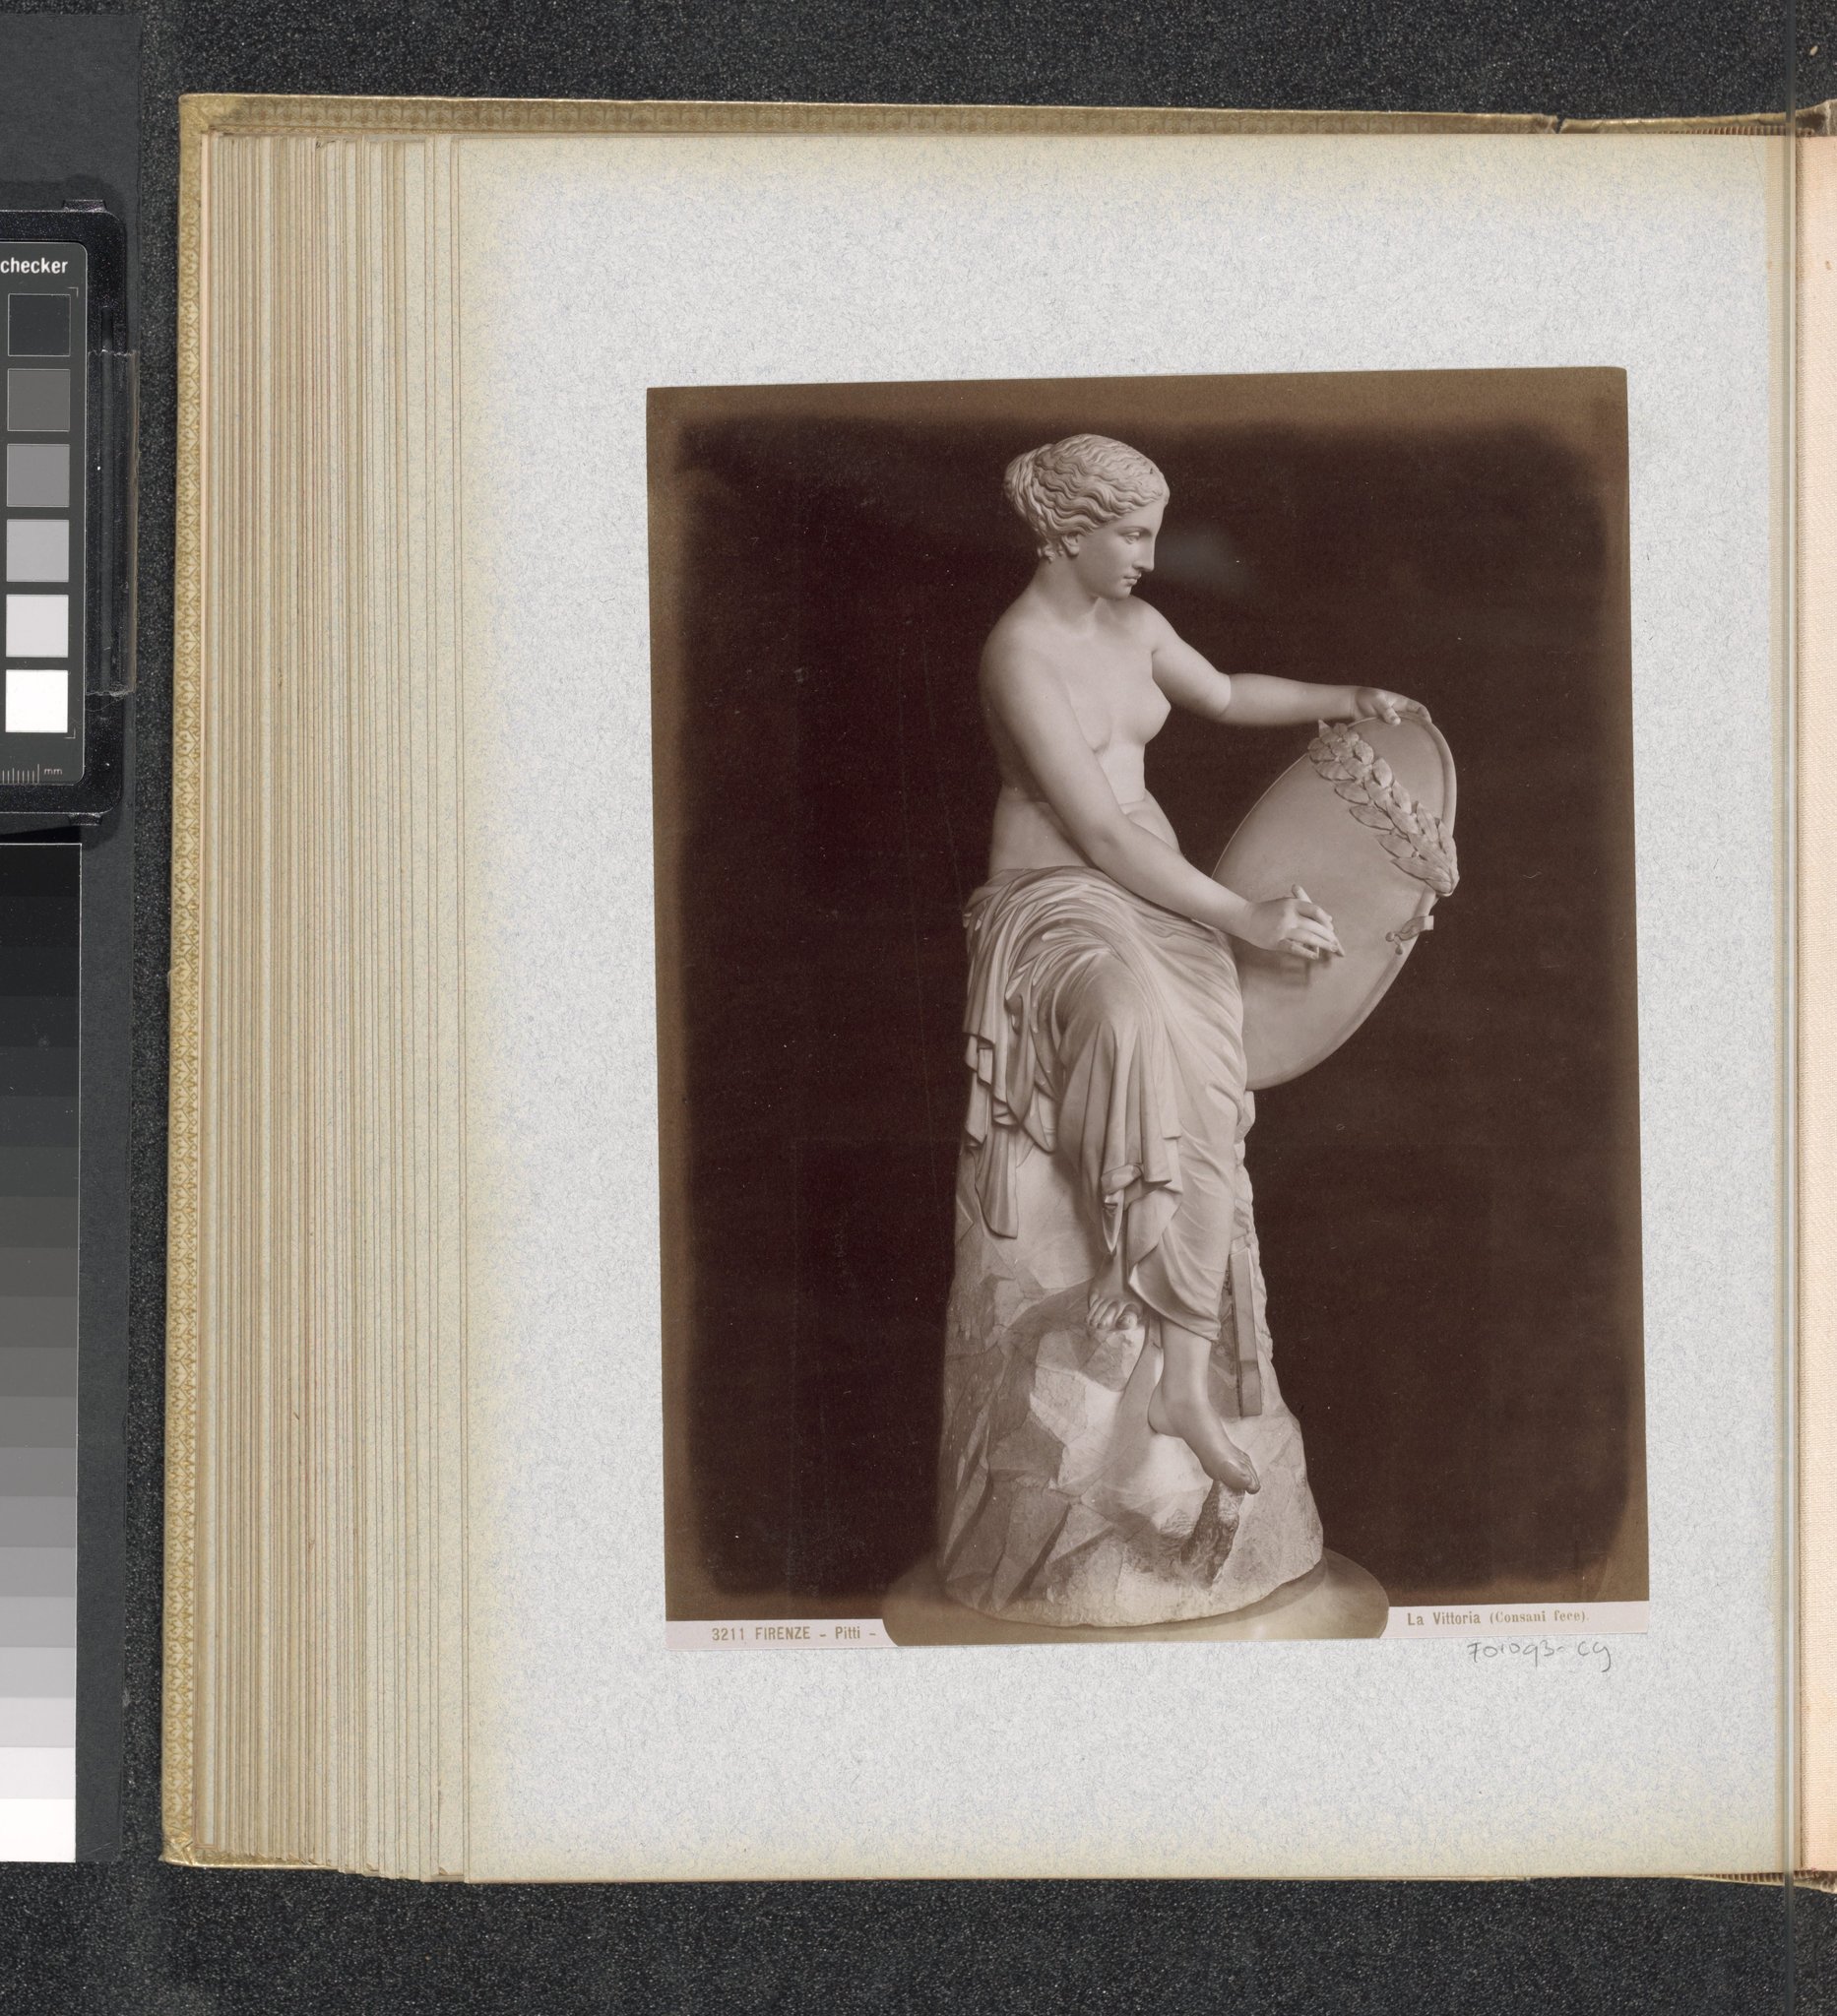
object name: photograph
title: Beeldhouwwerk 'La Vittoria' door Vincenzo Consani in het Palazzo Pitti in Florence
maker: Anonymous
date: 1870-1890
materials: paper, photographic support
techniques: albumen print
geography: florence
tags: piece of sculpture, reproduction of a piece of sculpture (+ sculpture), monument, statue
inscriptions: negative number: ‘3211’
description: Onderdeel van Reisalbum met foto's van bezienswaardigheden in Genua, Florence en Venetië.